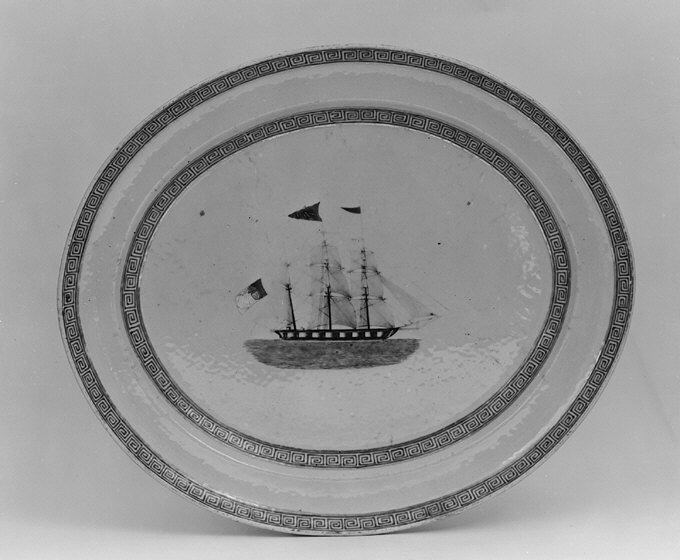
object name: platter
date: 1840-1849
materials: hard paste porcelain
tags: ships